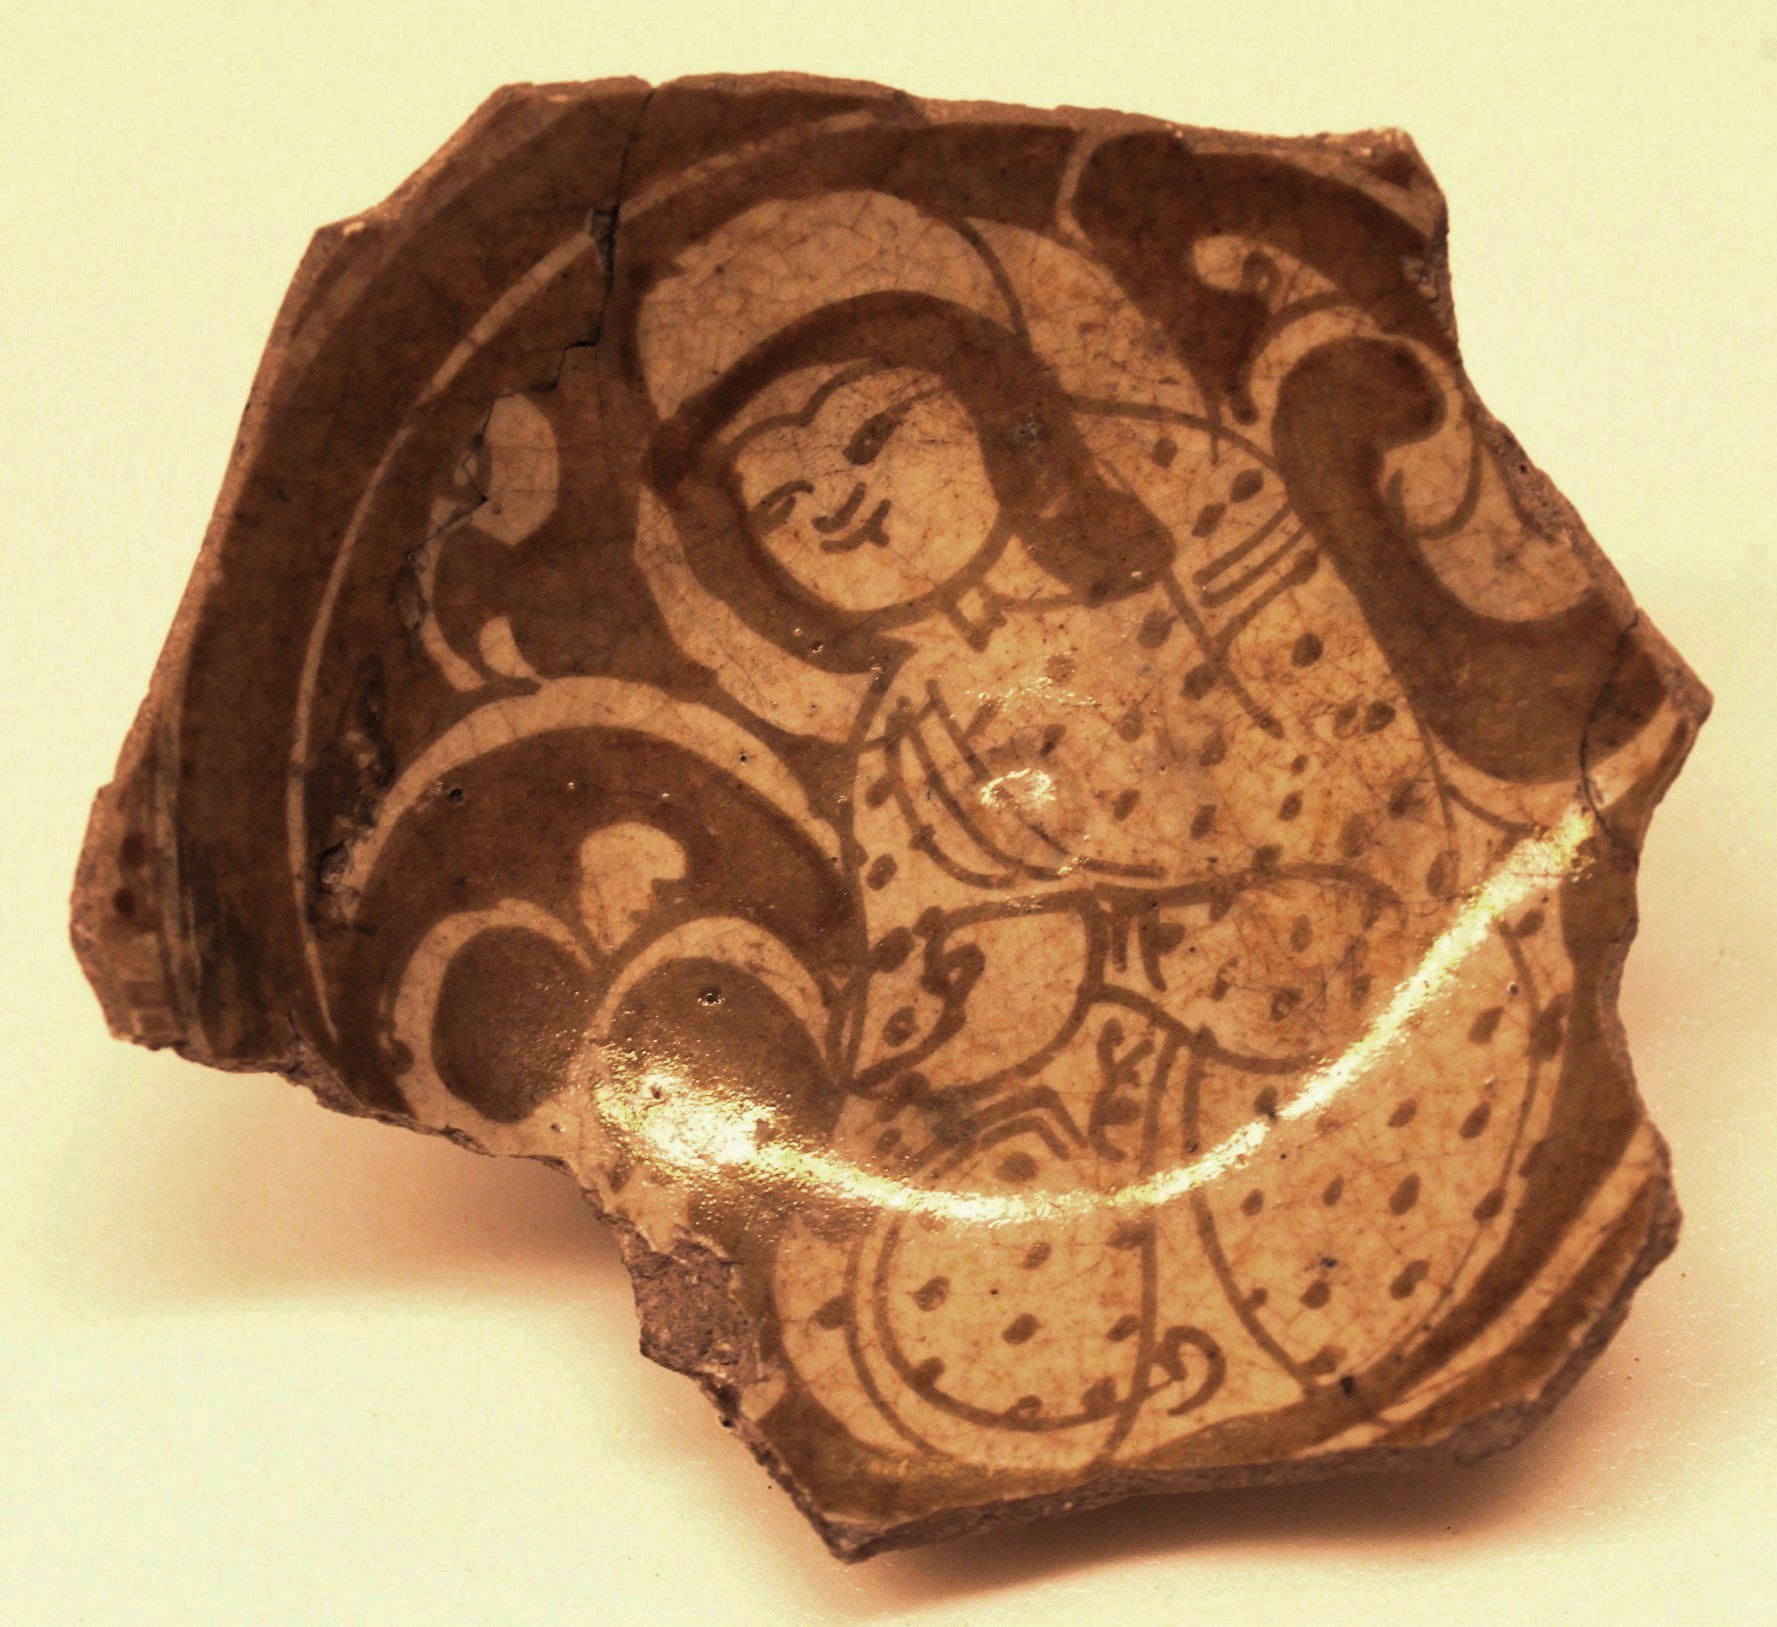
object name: fragment of a bowl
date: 1201-1300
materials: glaze, stonepaste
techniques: luster painting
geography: iran